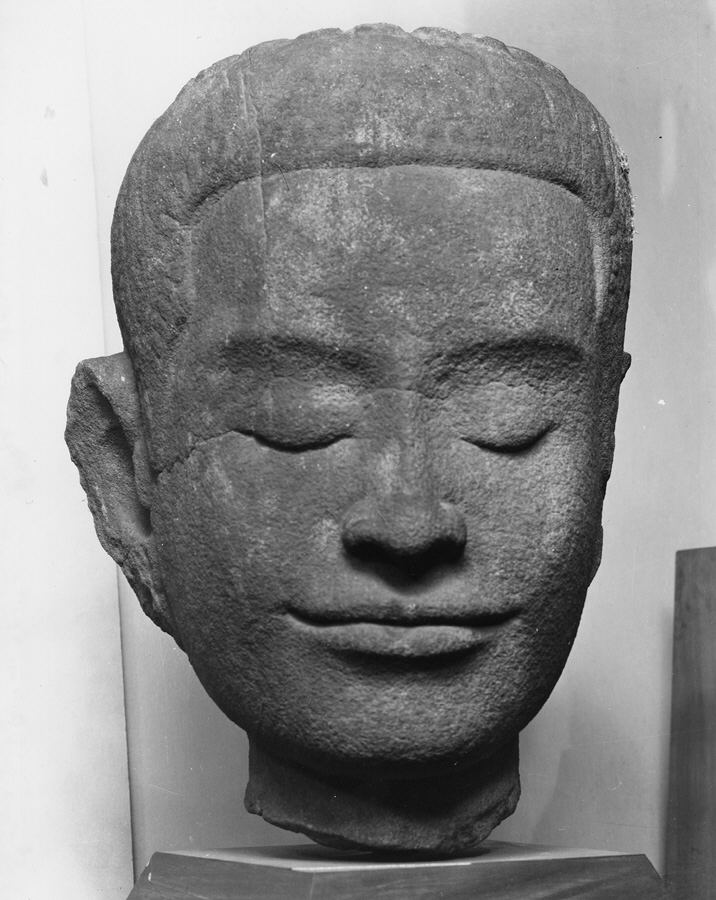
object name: head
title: Head of Buddha or Bodhisattva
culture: cambodian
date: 1101-1300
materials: stone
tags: heads,buddhism,bodhisattvas,buddha